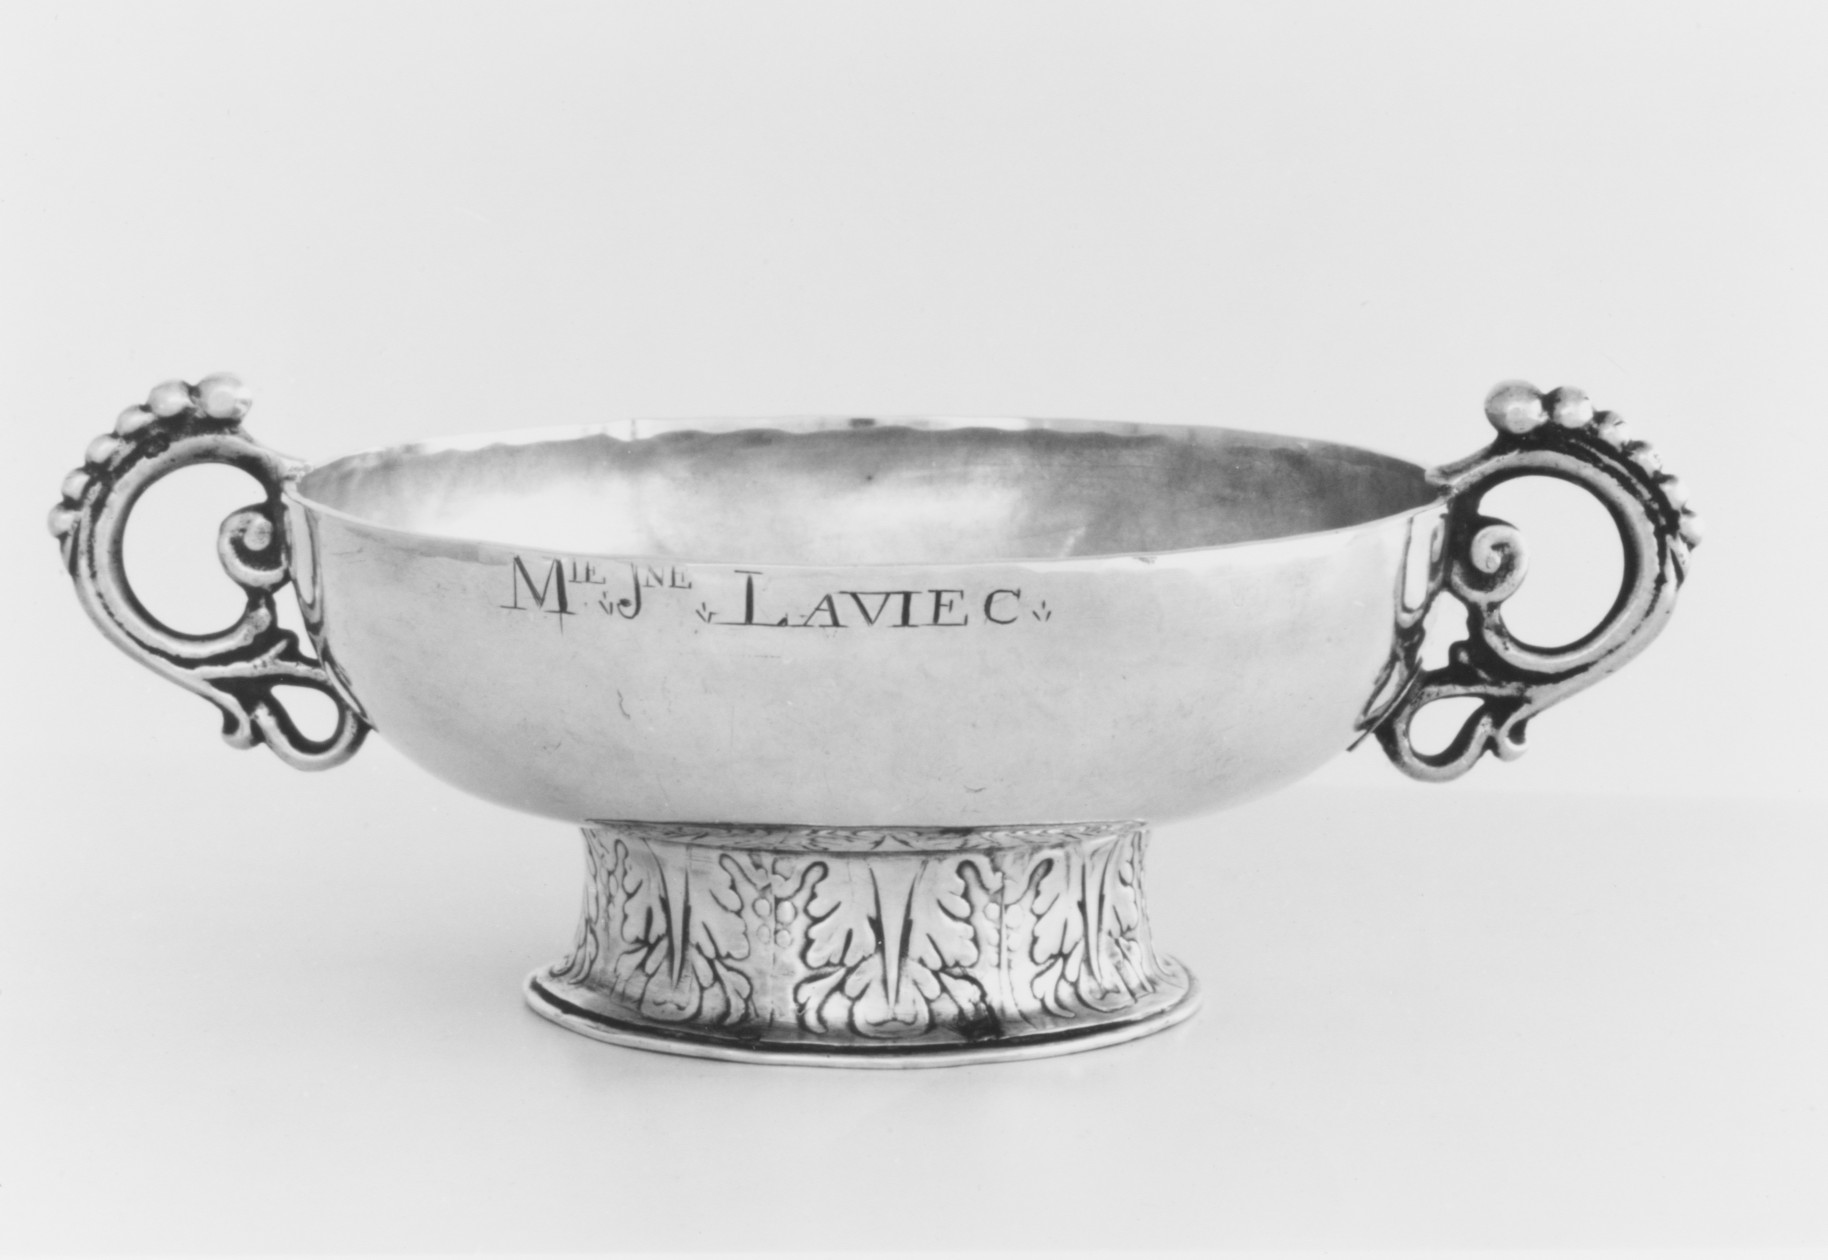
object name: collection cup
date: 1726-1750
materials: silver